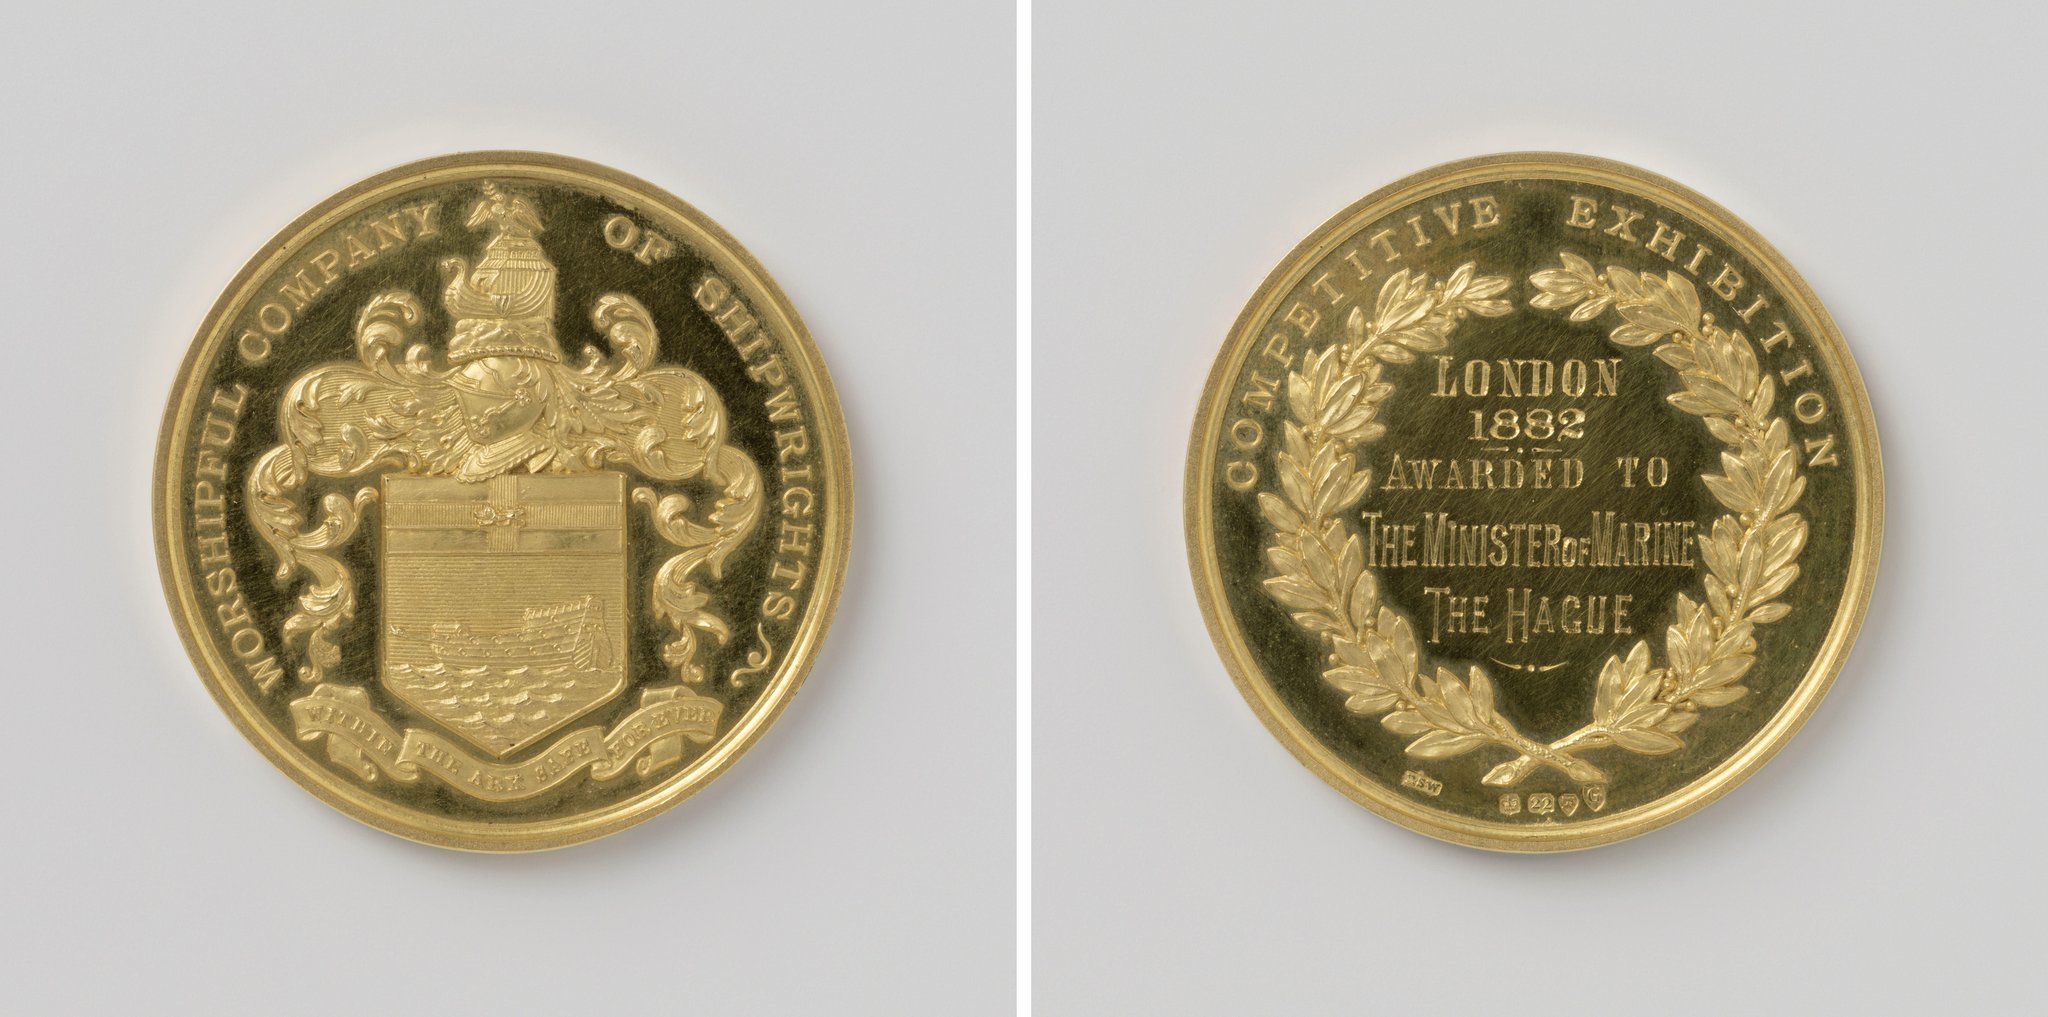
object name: medal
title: Prize Medal for the Department of the Navy, presented at the exhibition of the Worshipful Company of Shipwrights, Great Britain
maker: richard silvester warrington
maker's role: graveur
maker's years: 1822-1899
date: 1882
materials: gold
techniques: engraving, striking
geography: covent garden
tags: department of the navy, the hague, london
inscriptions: : ‘WORSHIPFUL COMPANY OF SHIPWRIGHTS / WITHIN THE ARK SAVE FOR EVER’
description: Gouden penning. Voorzijde: gehelmd wapenschild, bekroond met ark van Noach, waarop duif met olijftak in bek zit, boven wimpel met opschrift binnen omschrift. Keerzijde: opschrift binnen lauwerkrans en omschrift.